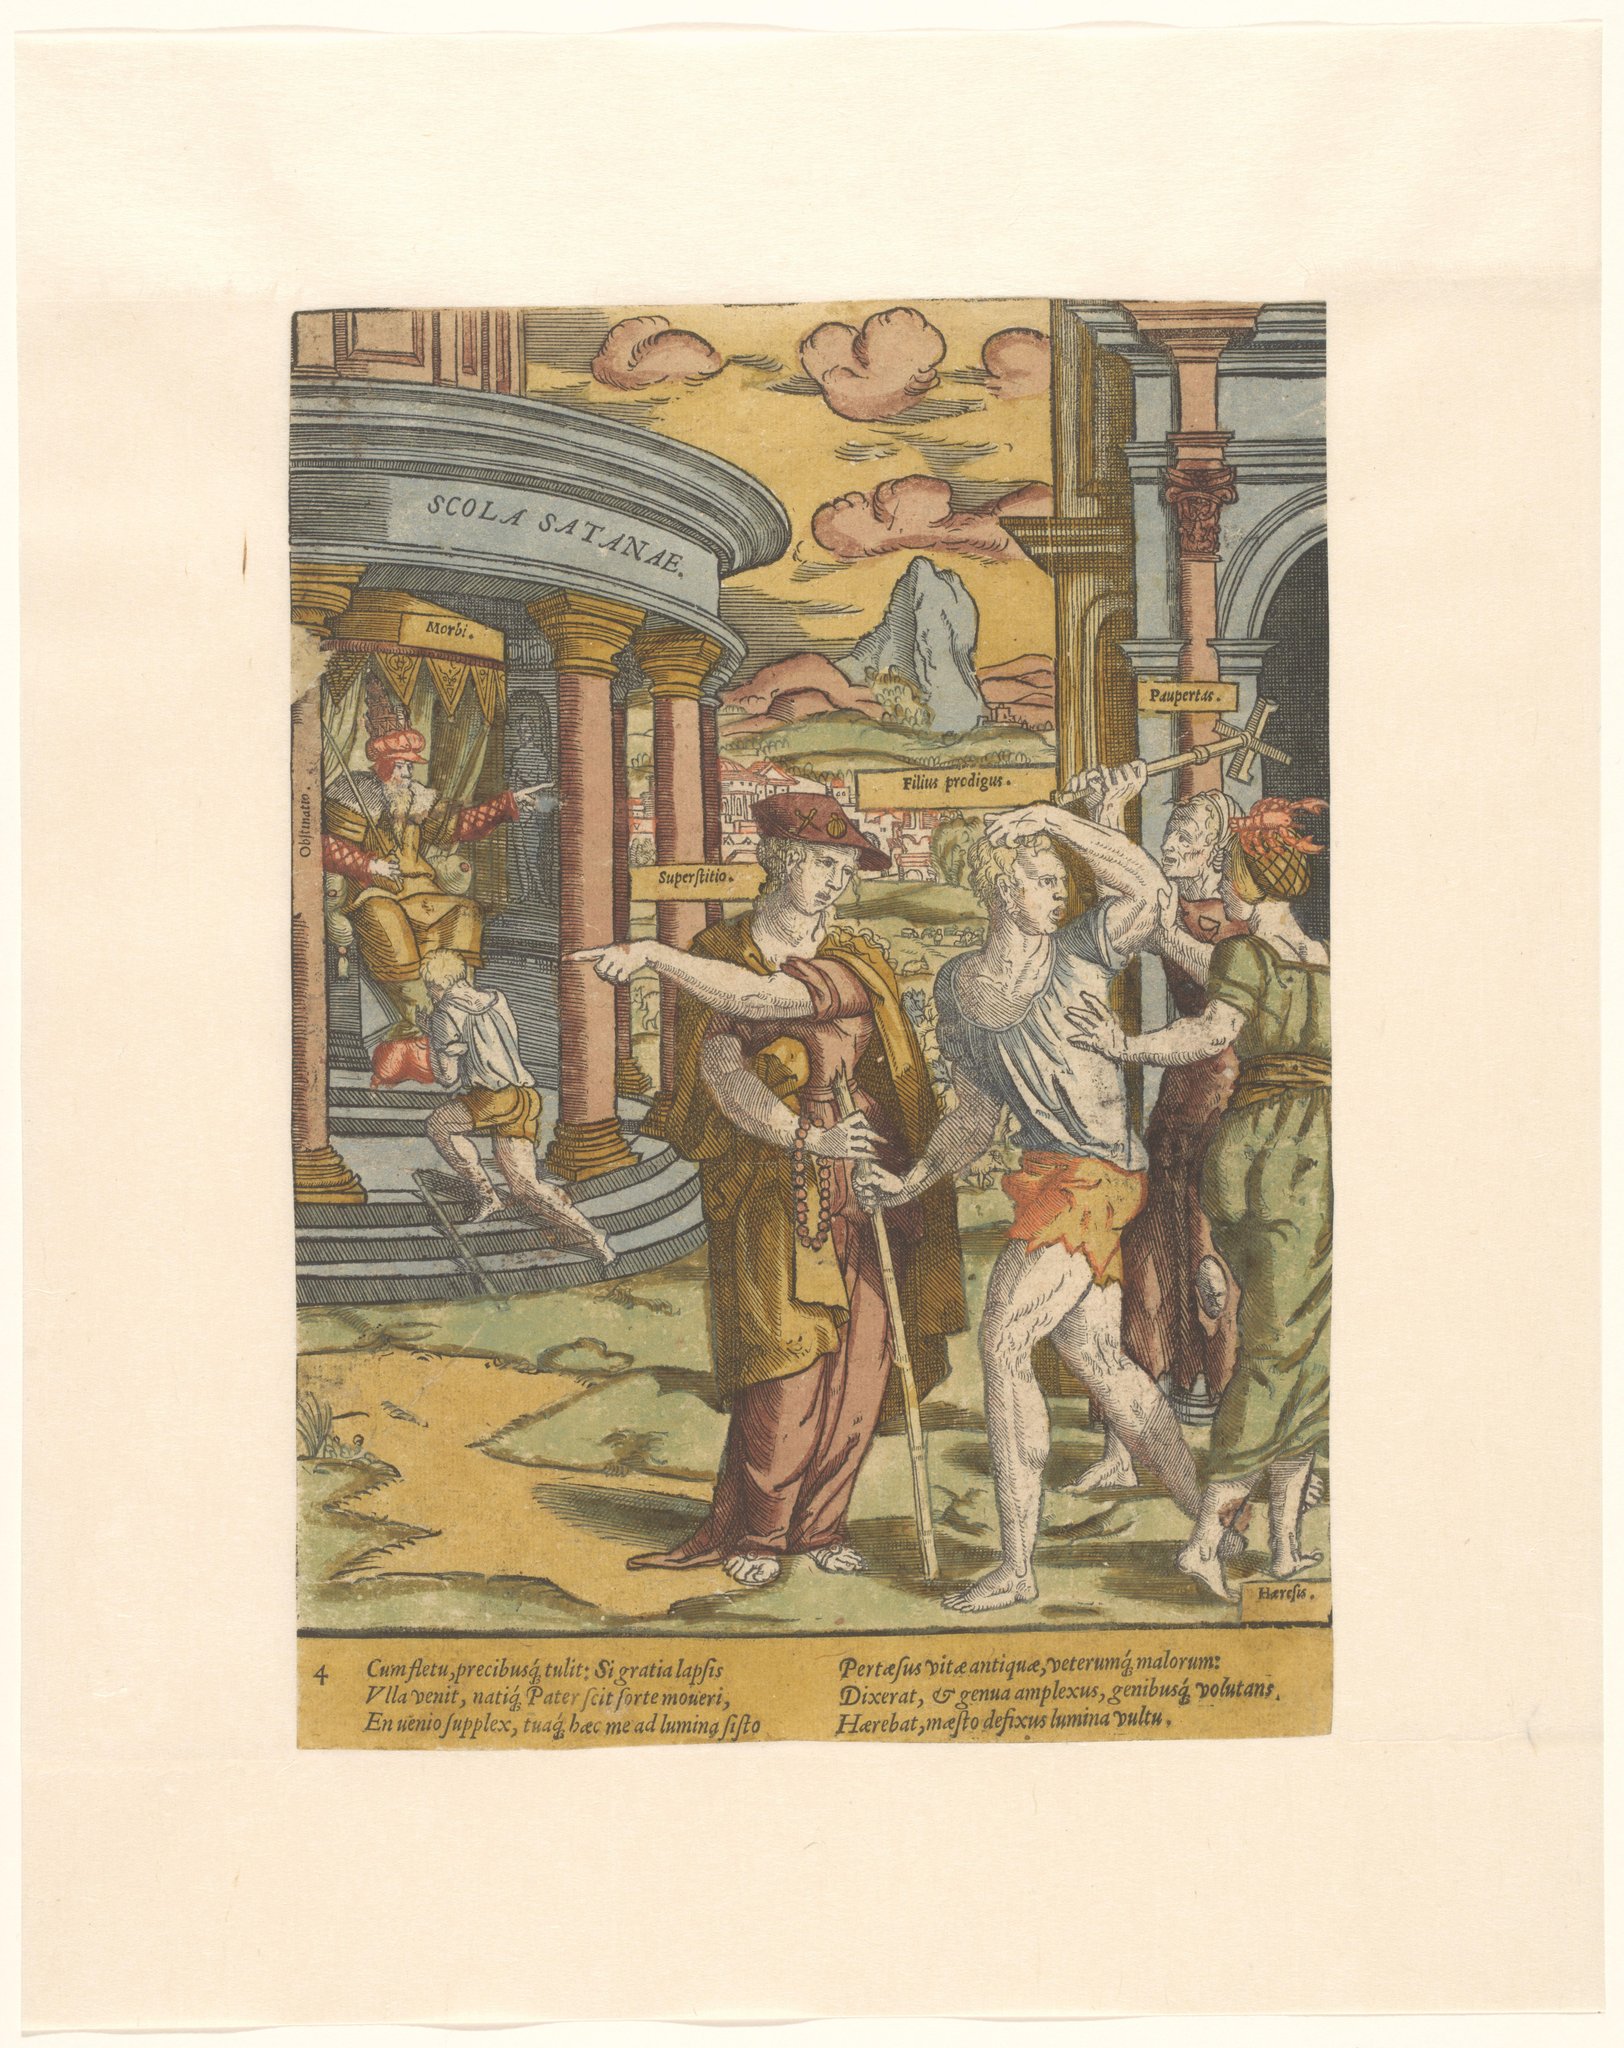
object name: print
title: De verdrijving van de verloren zoon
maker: cornelis anthonisz.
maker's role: draughtsman, painter, print maker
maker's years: 1499-1553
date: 1540-1550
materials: paint, paper, watercolor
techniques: letterpress printing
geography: amsterdam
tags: when all his money is squandered the prodigal son is chased away by the harlots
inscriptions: watermark: ‘kroon’, collector's mark: Lugt 2228, collector's mark: Lugt 2760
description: Eén van serie van zes. De zoon (Filius Prodigus) wordt door Armoede (Paupertas) verdreven, terwijl Bijgeloof (Superstitio) en Ketterij (Haeresis) hem de weg wijzen naar de Synagoge van Satan (Synagoga Sathanae). Daar knielt hij voor een man op een troon. Op de troon staat het woord Ziekte (Morbus), op de zuil Eigenwijsheid (Obstinatio). Prent uit reeks van zes houtsneden met de Geschiedenis van de verloren zoon met zesregelige Latijnse onderschriften in boekdruk. De houtsnede is handgekleurd waarbij de kostuums van de voorgestelde personen zijn aangepast / gemoderniseerd.